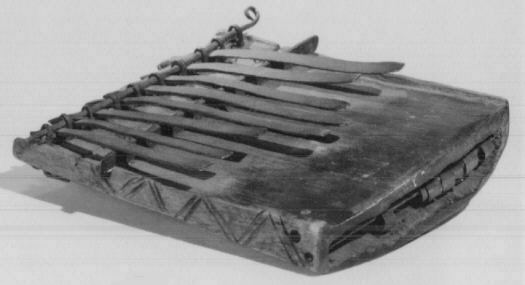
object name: sansa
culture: african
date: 1850-1889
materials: cord, metal, wood